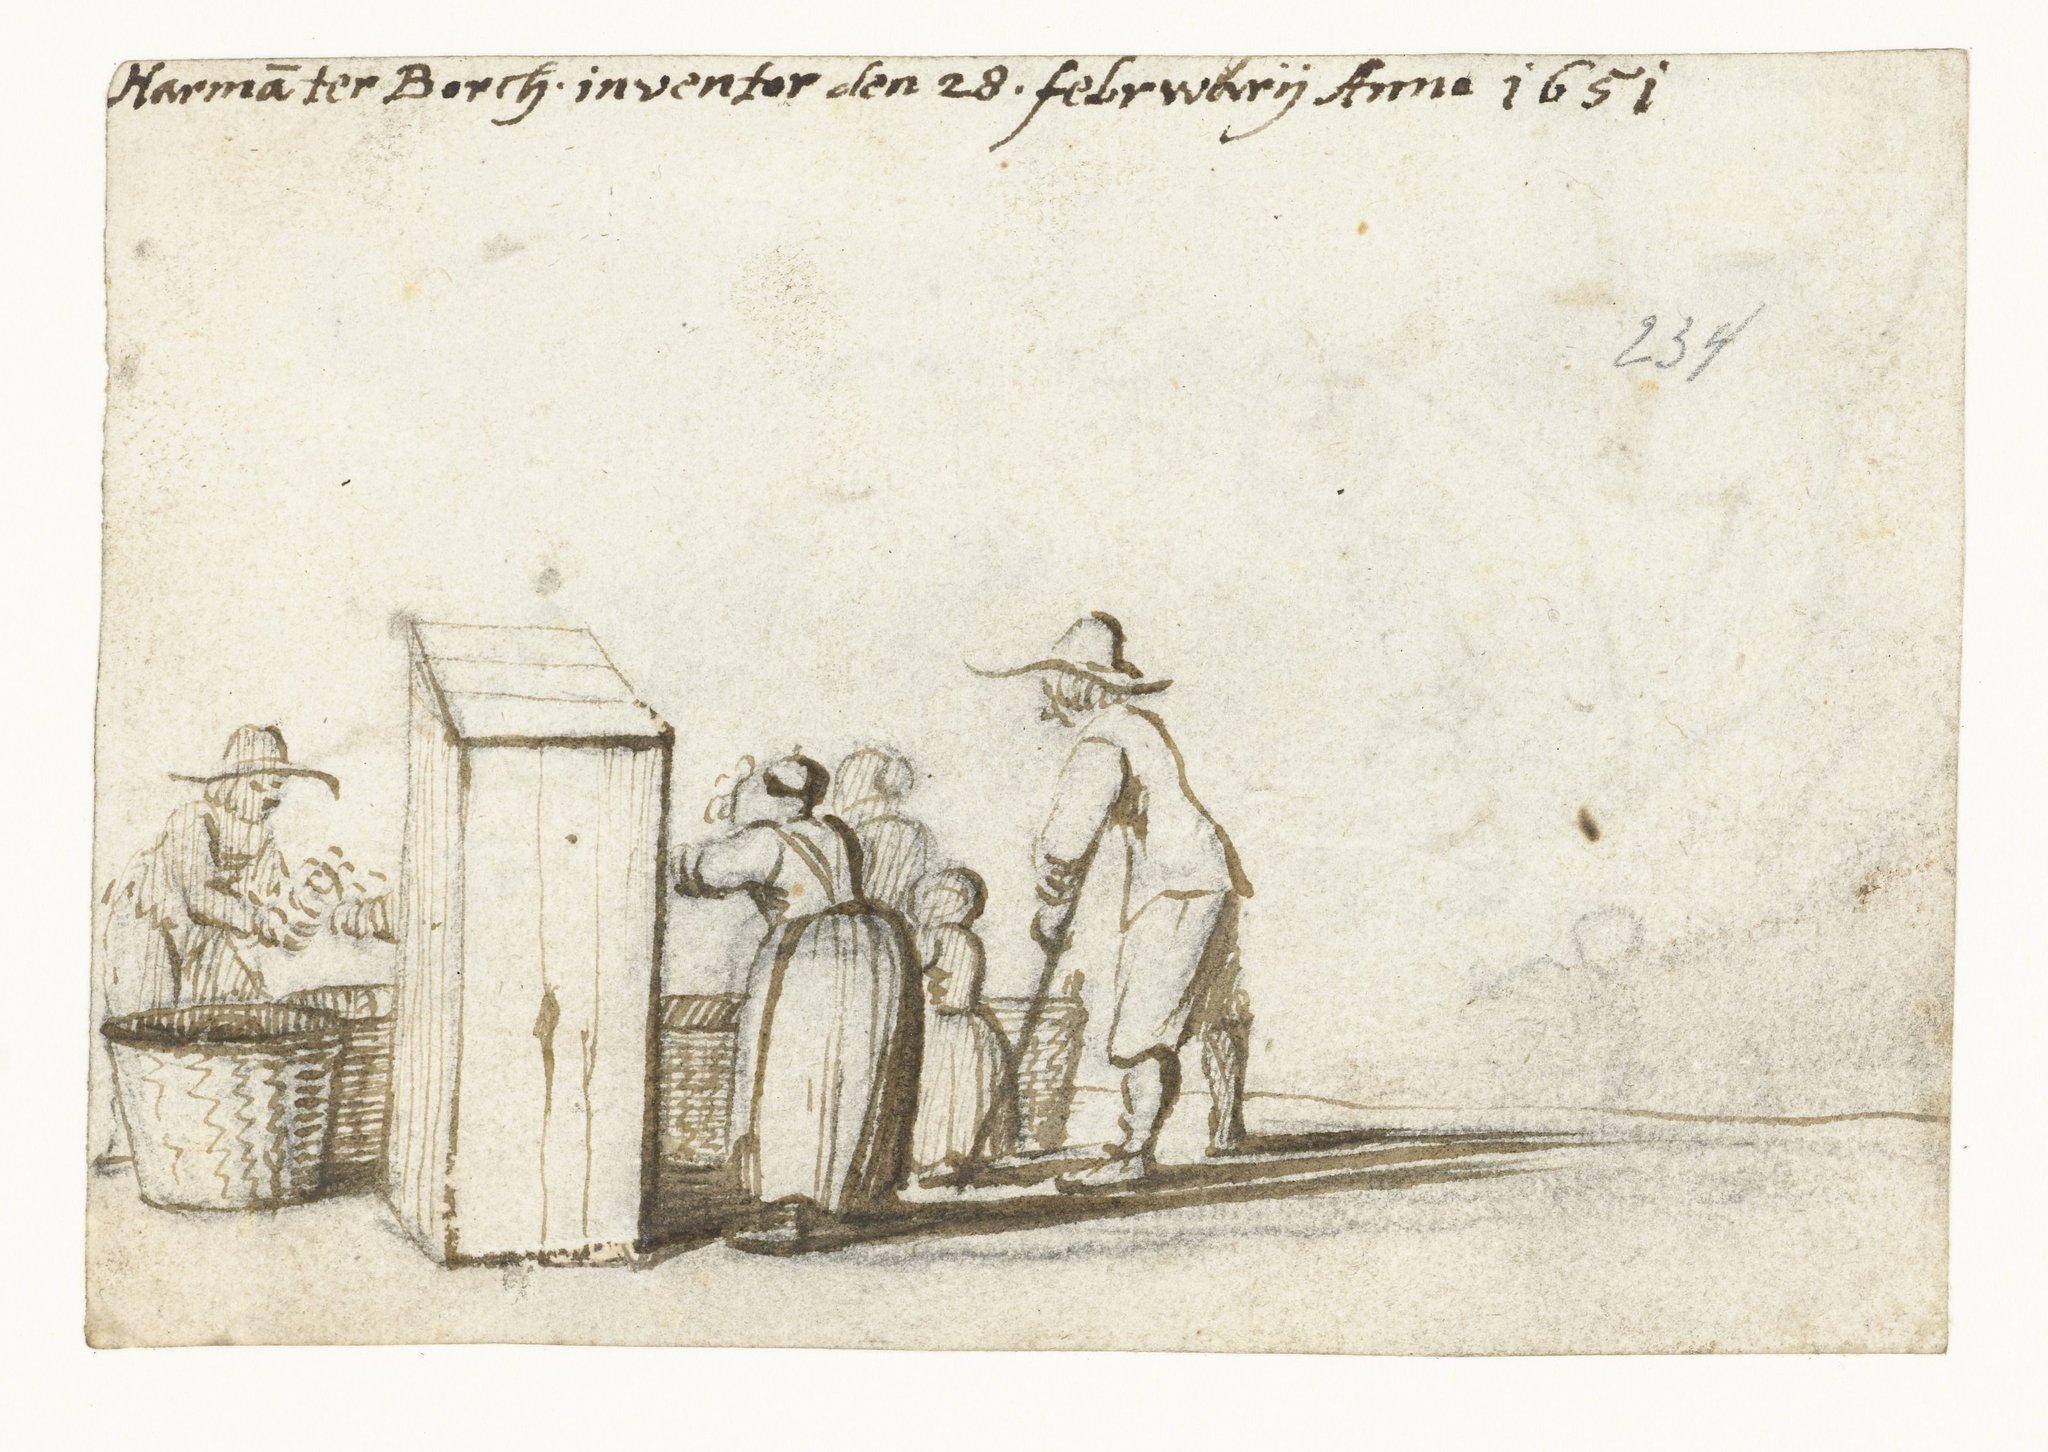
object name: drawing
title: Groentemarkt, van achteren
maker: harmen ter borch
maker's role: draughtsman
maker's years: 1638-1677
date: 1651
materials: chalk, ink, paper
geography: zwolle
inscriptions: annotation: ‘Harma[n] ter Borch. inventor den 28. febrwarij Anno 1651’